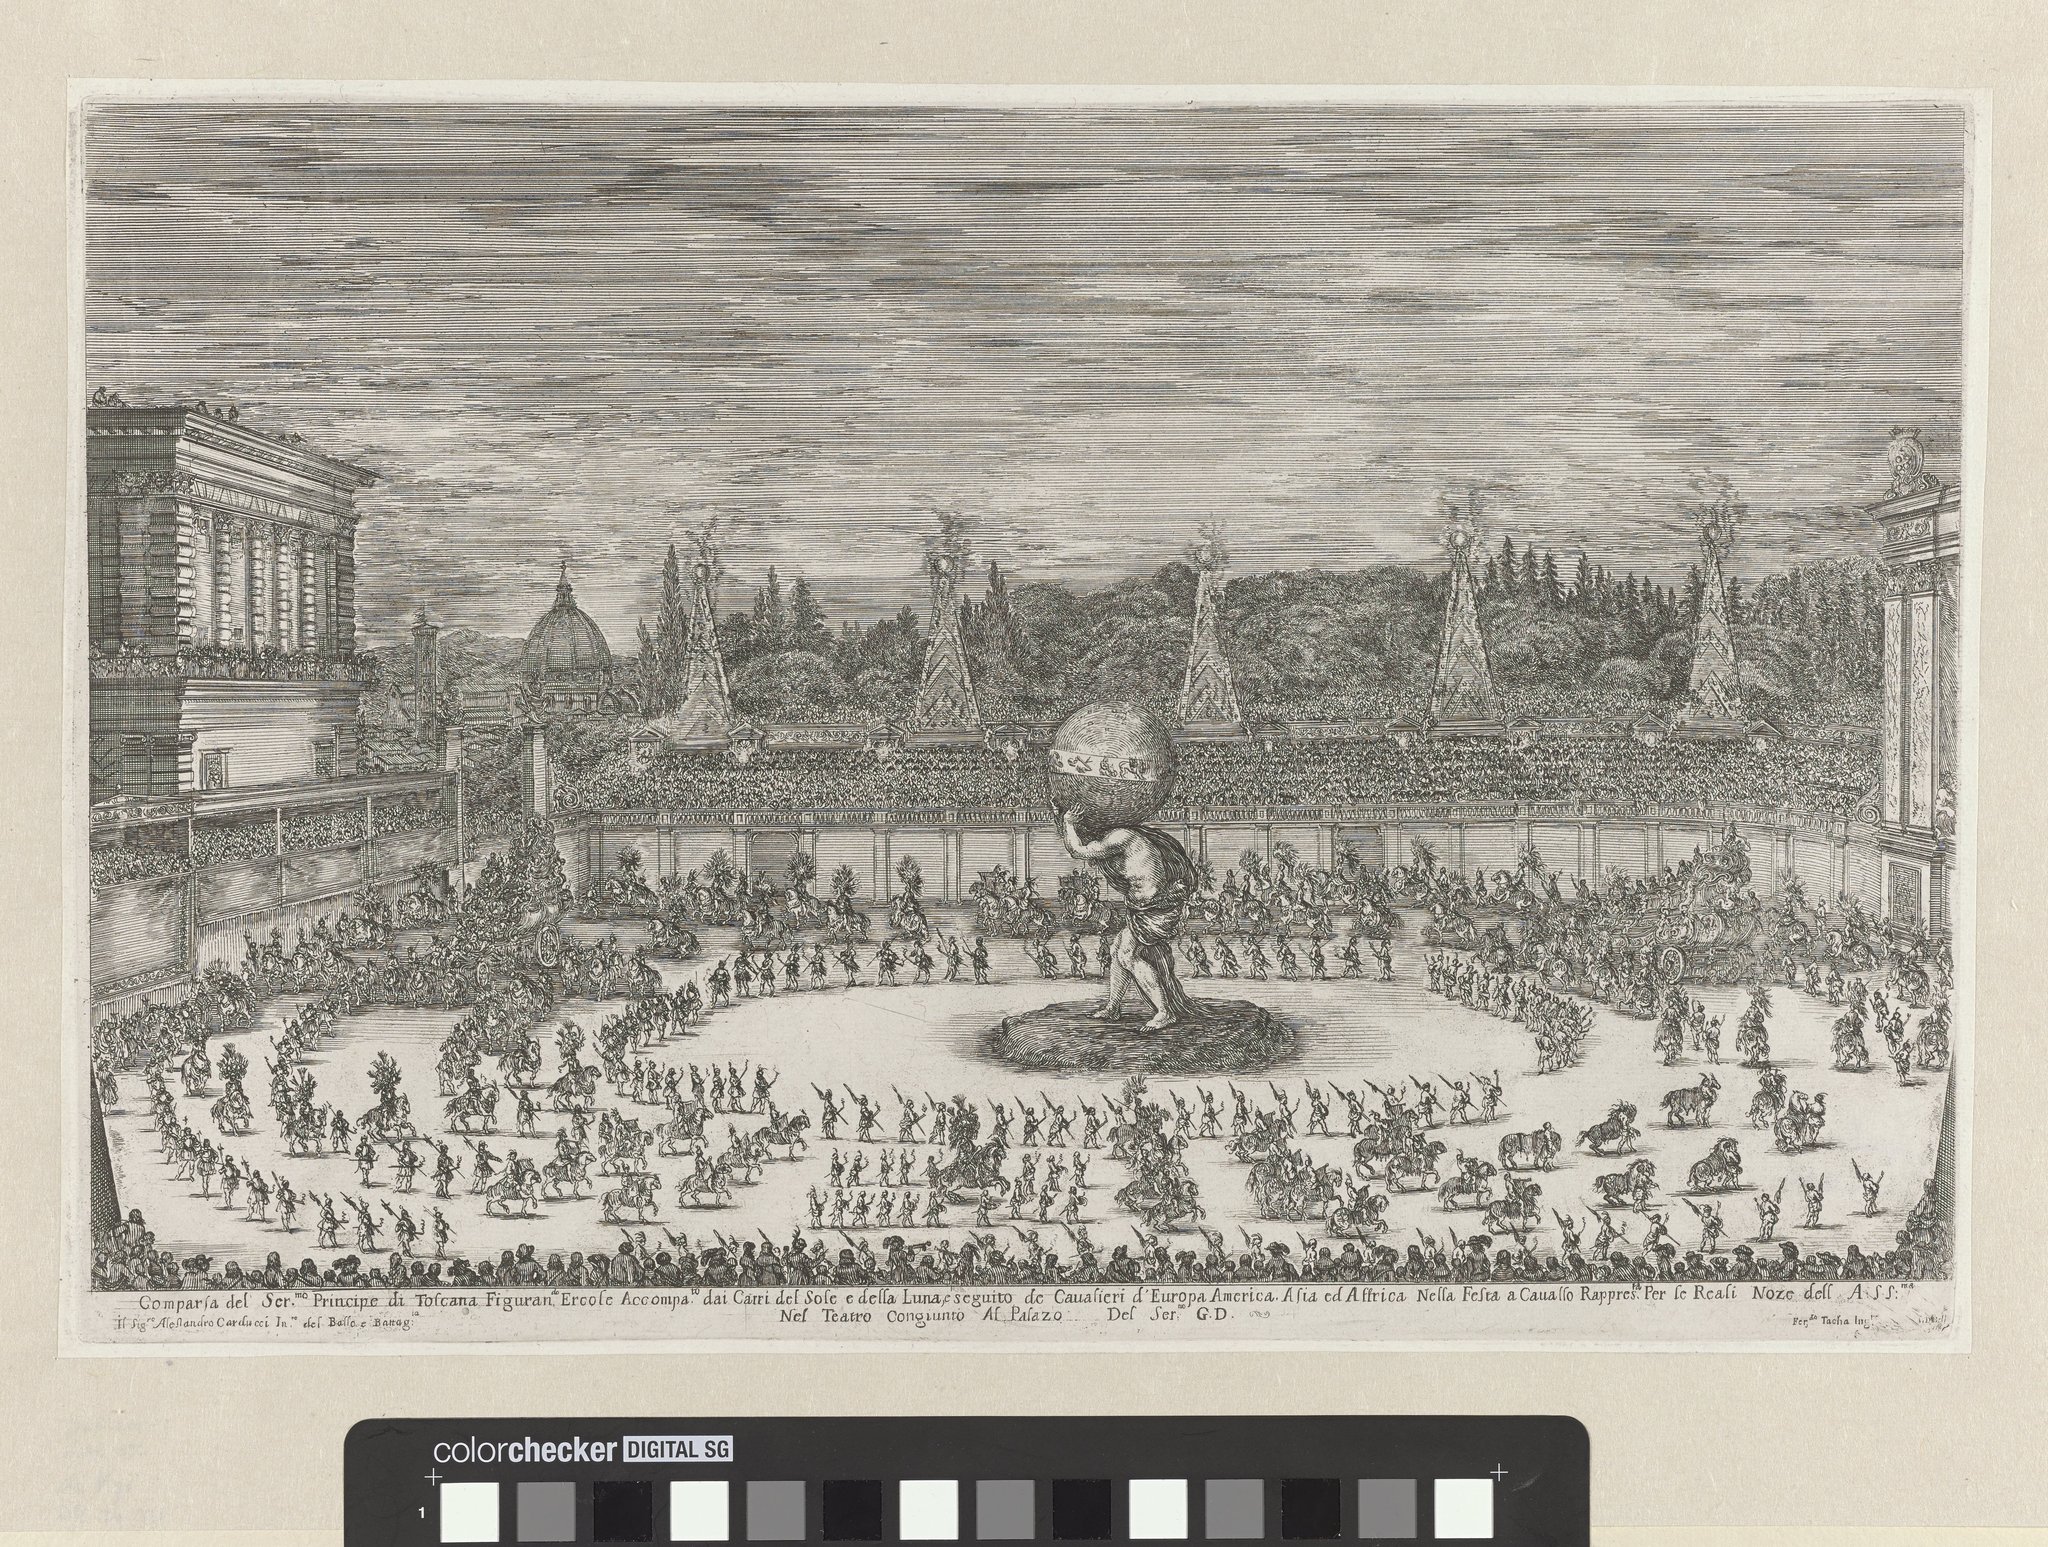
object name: print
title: Carroussel ter ere van het huwelijk van Cosimo III en Marguerite Louise d'Orléans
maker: stefano della bella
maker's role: draughtsman, print maker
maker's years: 1610-1664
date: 1661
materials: paper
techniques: etching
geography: italy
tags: riding a horse, ass, or mule; rider, horseman, (story of) hercules (heracles), festivities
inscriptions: collector's mark: Lugt 240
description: Reeks van 3 prenten met voorstellingen van een carroussel ter ere van het huwelijk van Cosimo III en Marguerite Louise d'Orléans op 1 juli 1661. Prent gebruikt als illustratie in 'Il Mondo festeggiante: balletto a cavallo fatto nel teatro congiunto al palazzo del Sereniss. Gran Duca, per le reali nozze de' Serenissimi Principi Cosimo terzo di Toscana e Margherita Luisa d'Orleans', Florence 1661. Getekende voorstudie wordt bewaard in de Galleria degli Uffizi te Florence (inv. nr. 8068 F).